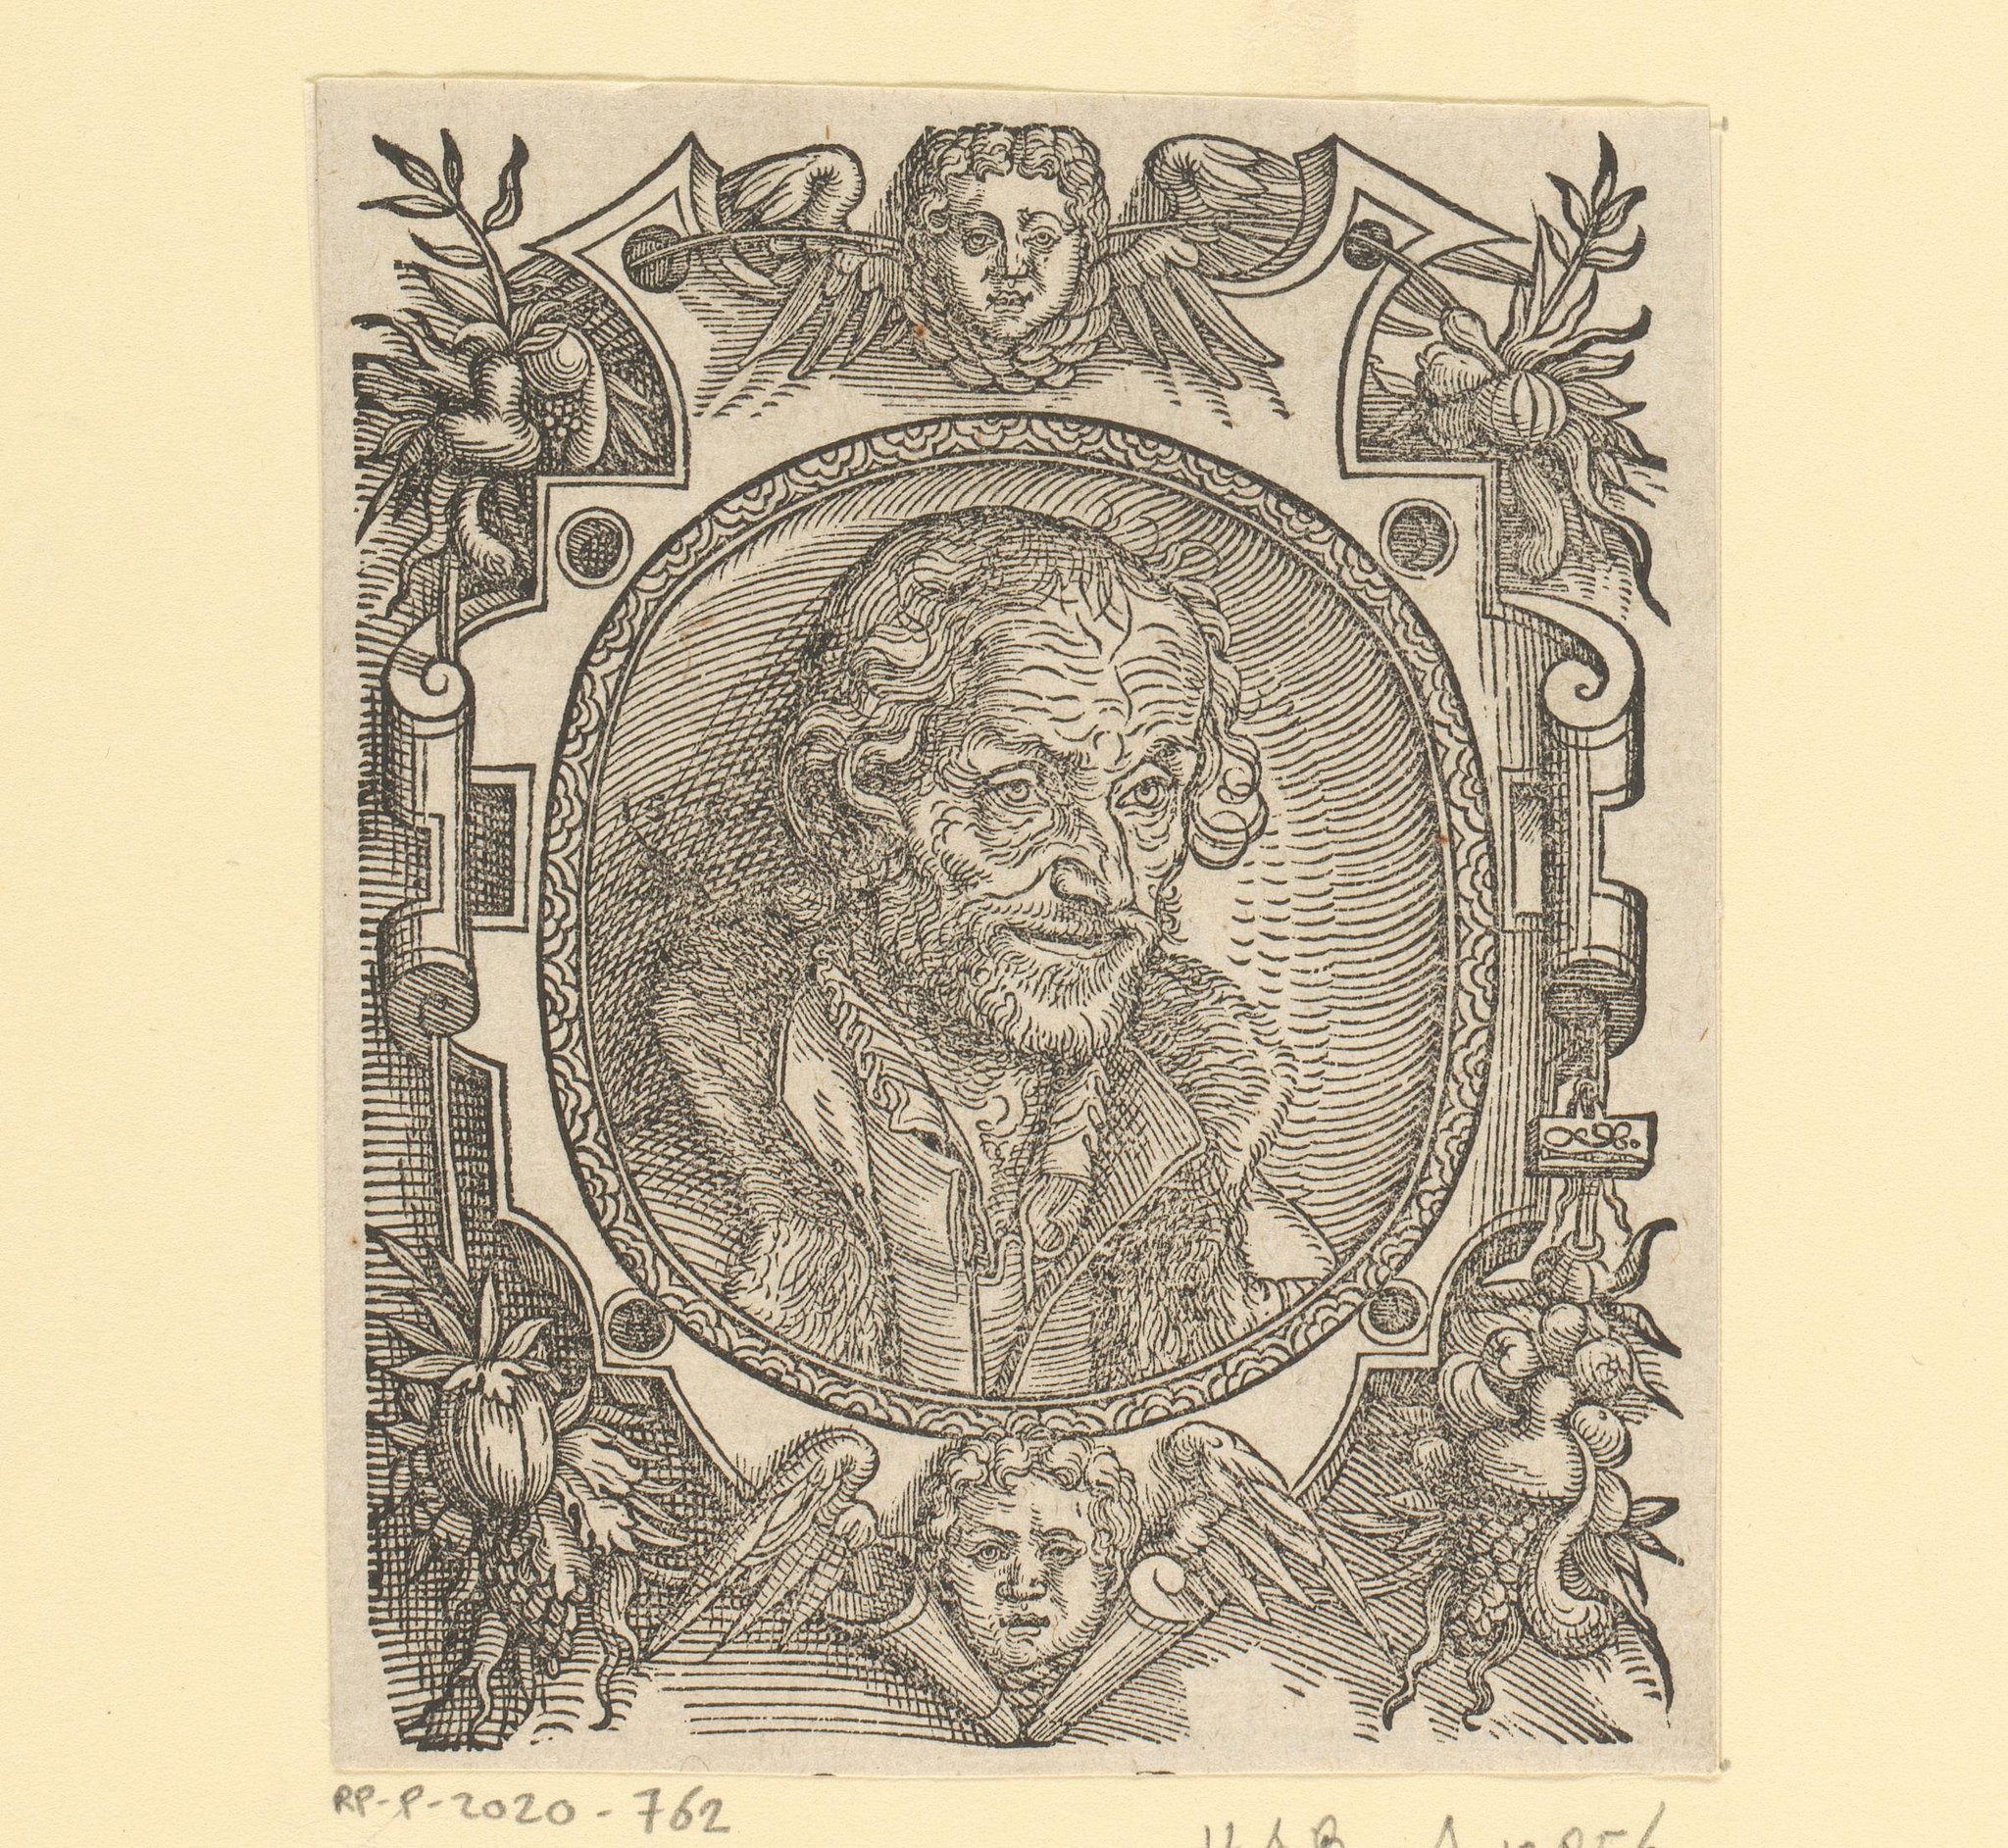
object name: print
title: Portret van Philipp Melanchthon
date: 1572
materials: paper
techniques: woodcut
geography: wittenberg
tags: theologian, historical persons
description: Prent uit: Melanchthon, Philipp en Caspar Peucer. Chronicon Carionis: expositum et auctum multis et veteribus et recentibus (...). Wittenberg: Johann Krafft, 1572.